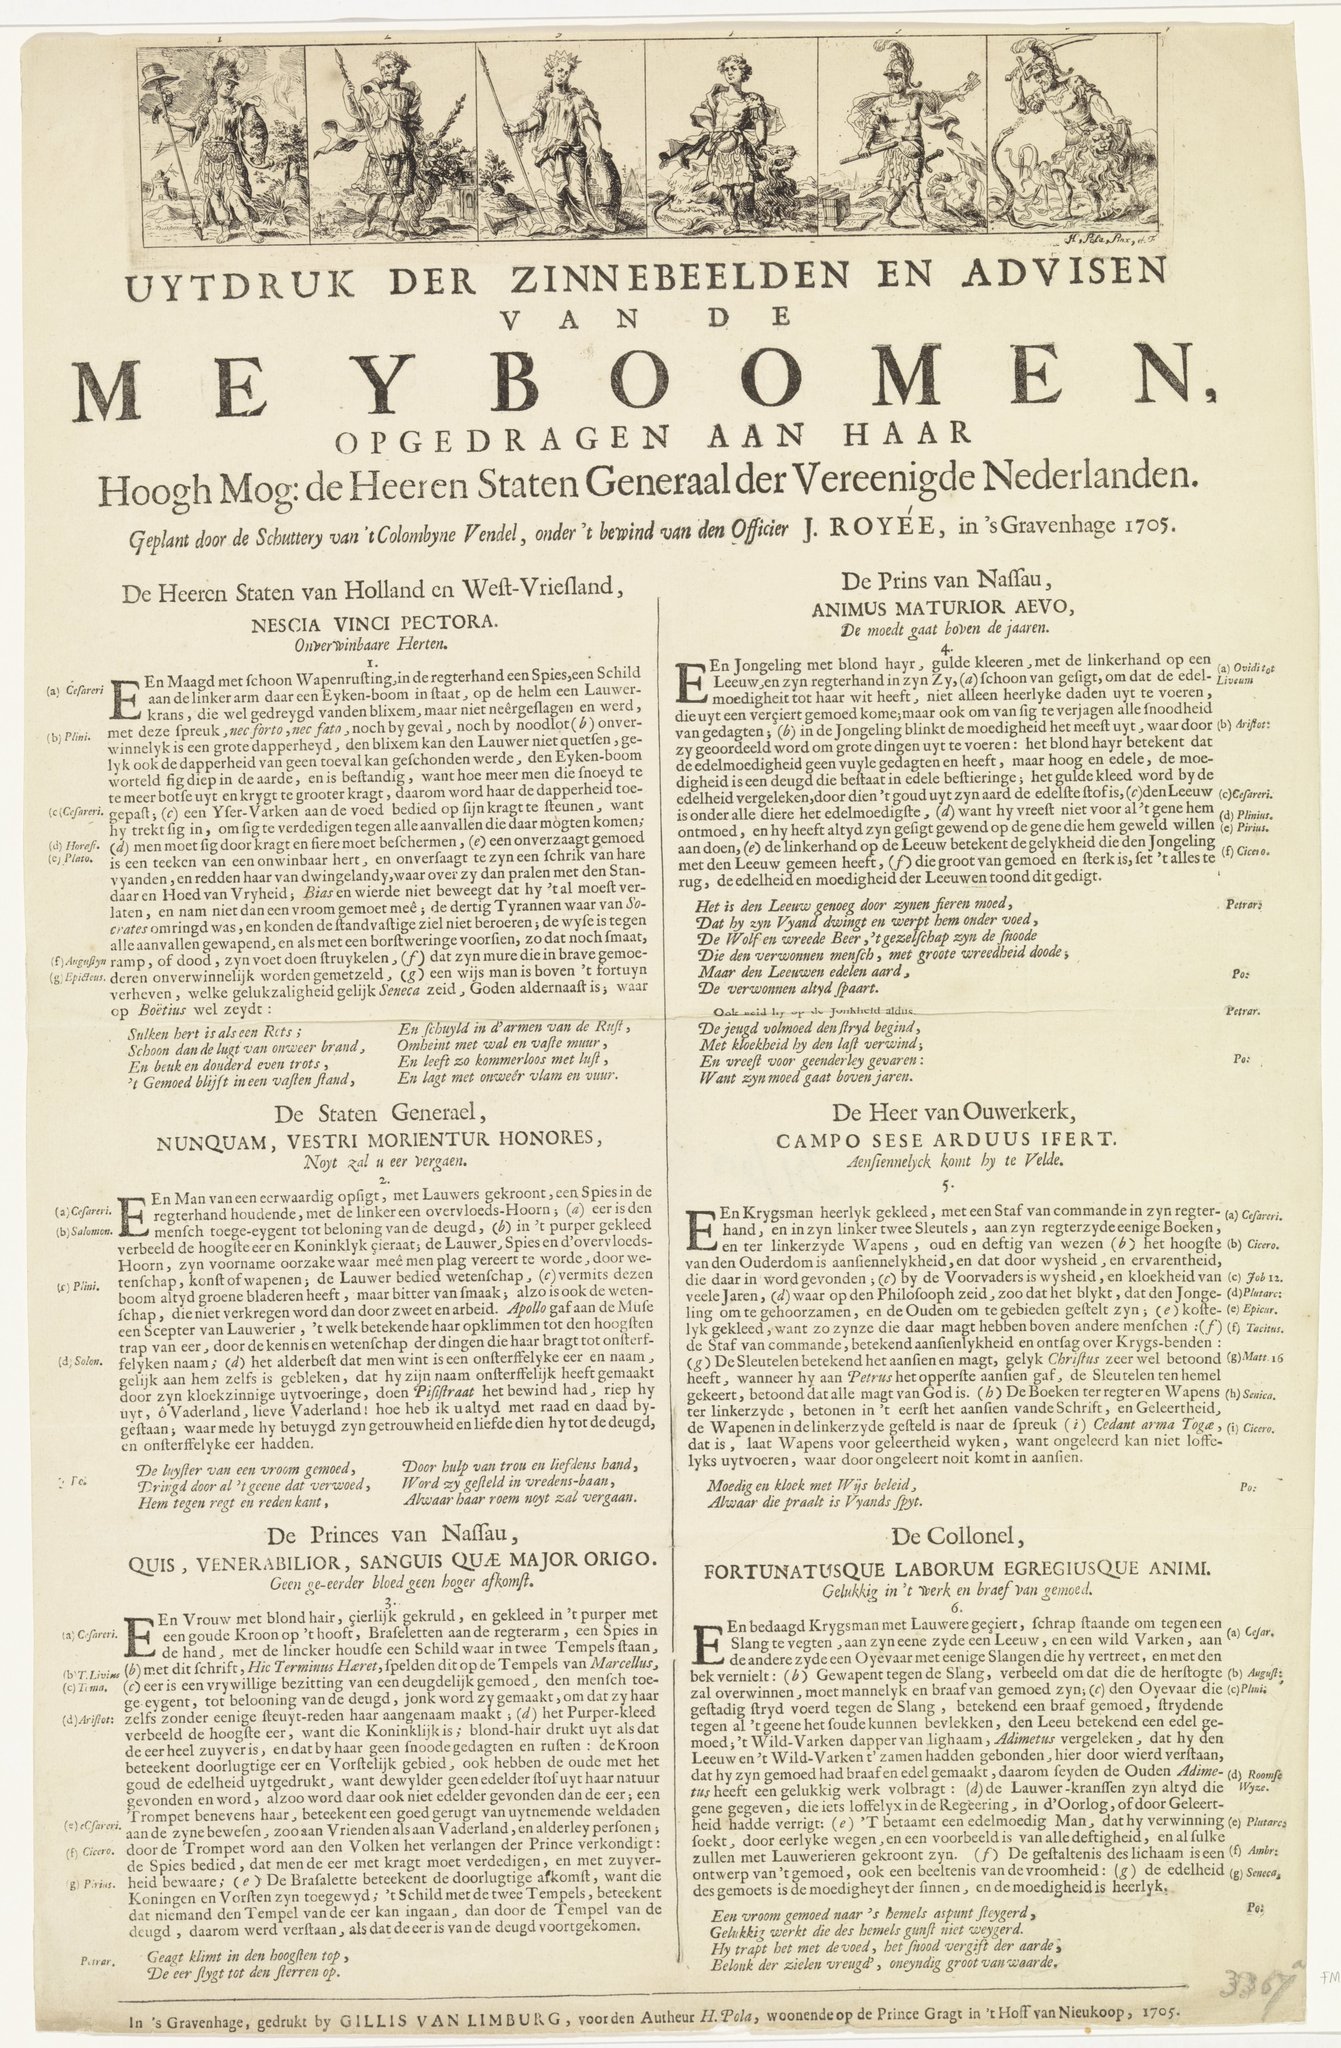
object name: text sheet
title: Uytdruk der Zinnebeelden en Advisen van de Meyboomen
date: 1705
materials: paper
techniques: etching, letterpress printing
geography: the hague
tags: johan willem friso (prins van oranje-nassau), mayor, mr. paulus van assendelft, maypole, the hague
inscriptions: collector's mark: Lugt 2228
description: Uitleg van de zes zinnebeelden op de meibomen opgericht door de schutterij van 't Colombyne Vendel van de officier J. Royer te Den Haag, 1705. Bovenaan zes allegorische figuren verwijzende naar de Staten van Holland en West-Friesland, de Staten-Generaal, de prins en prinses van Oranje, de heer van Ouwerkerk en de Colonel P. van Assendelft.